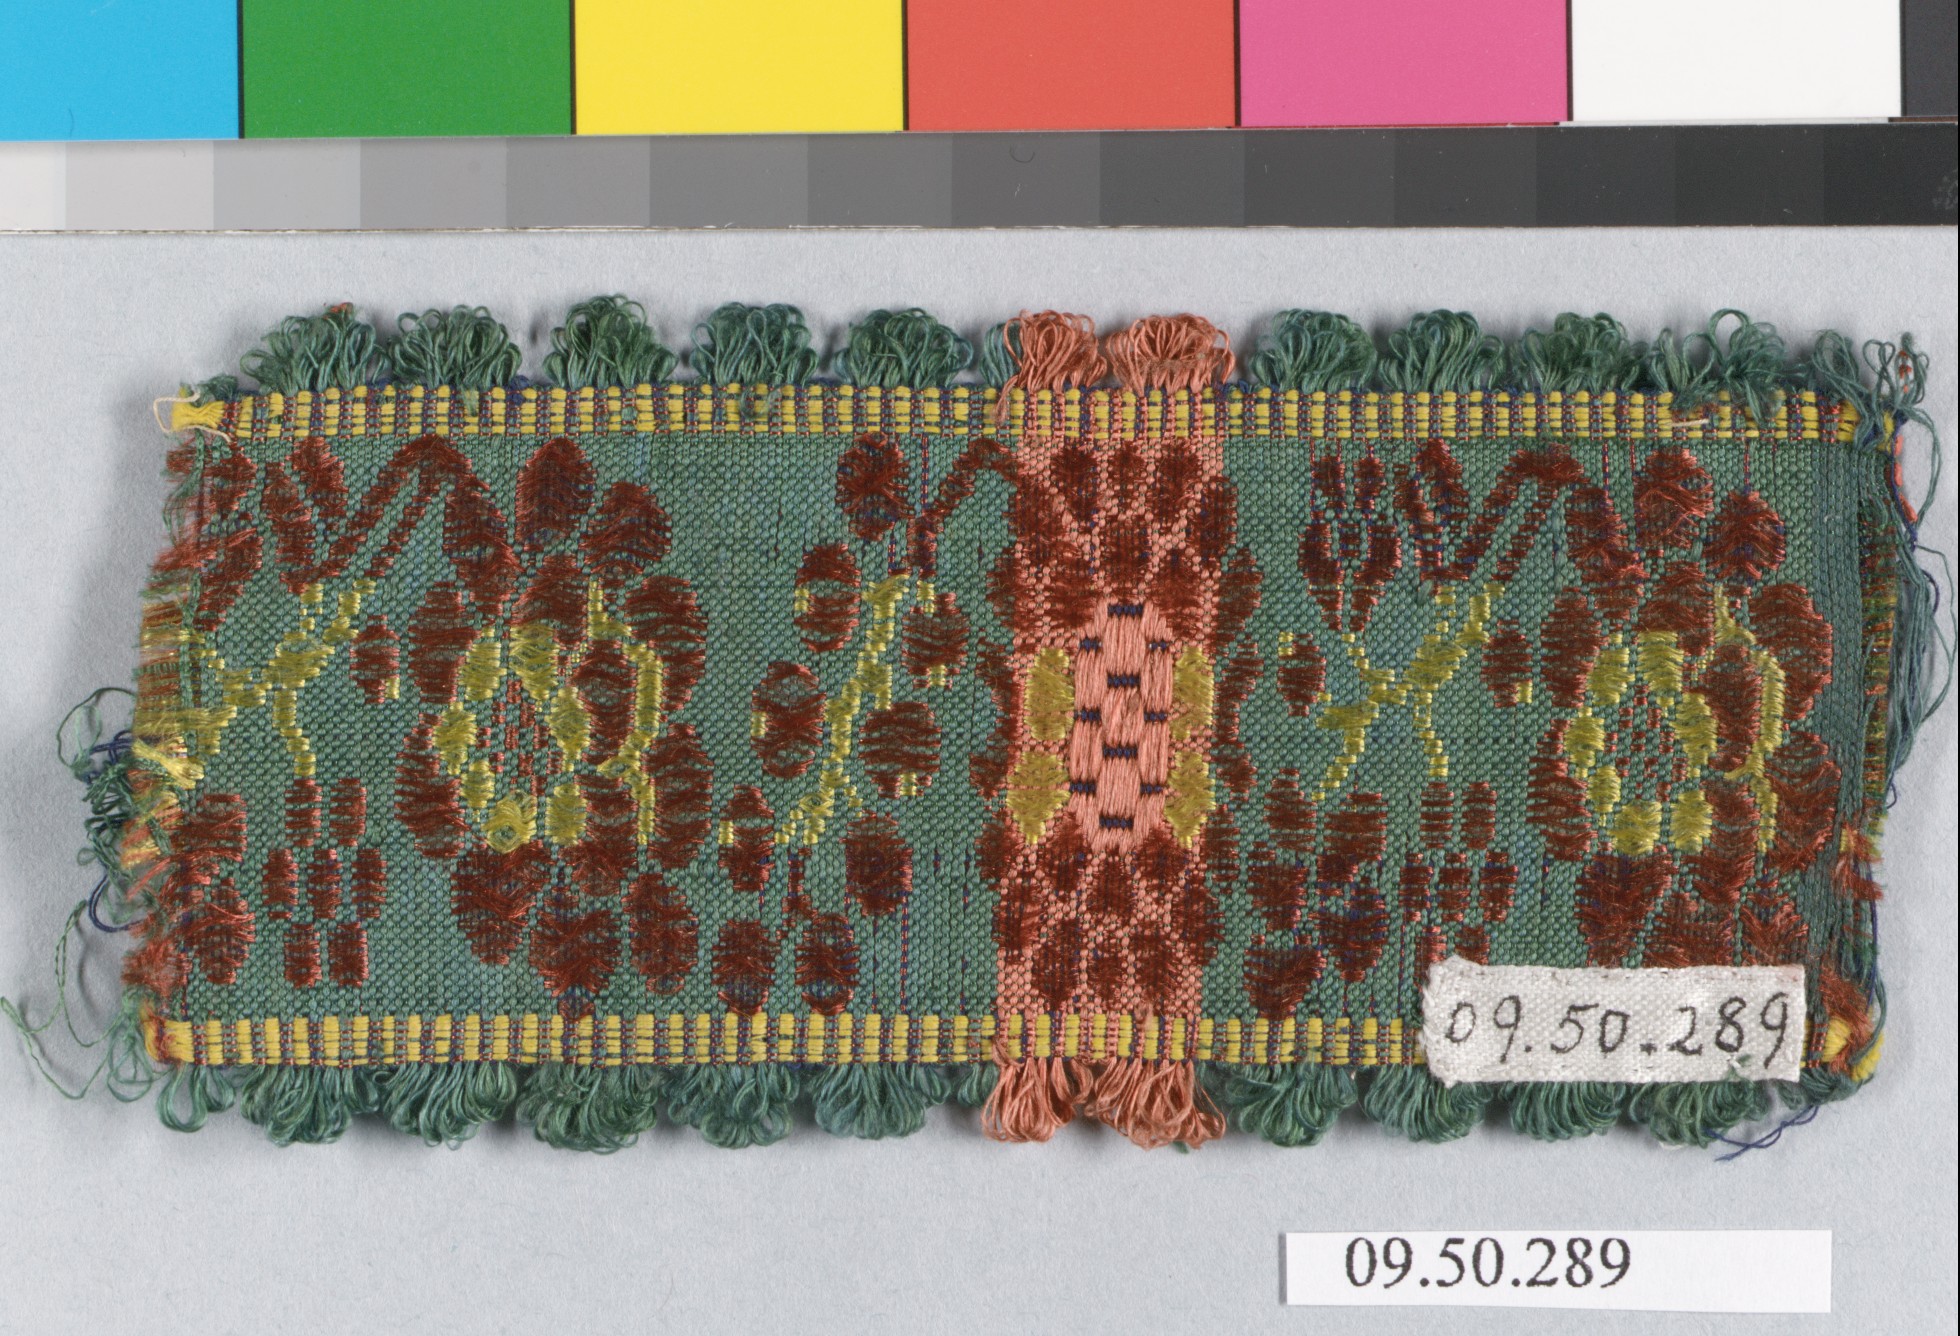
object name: ribbon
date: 1801-1833